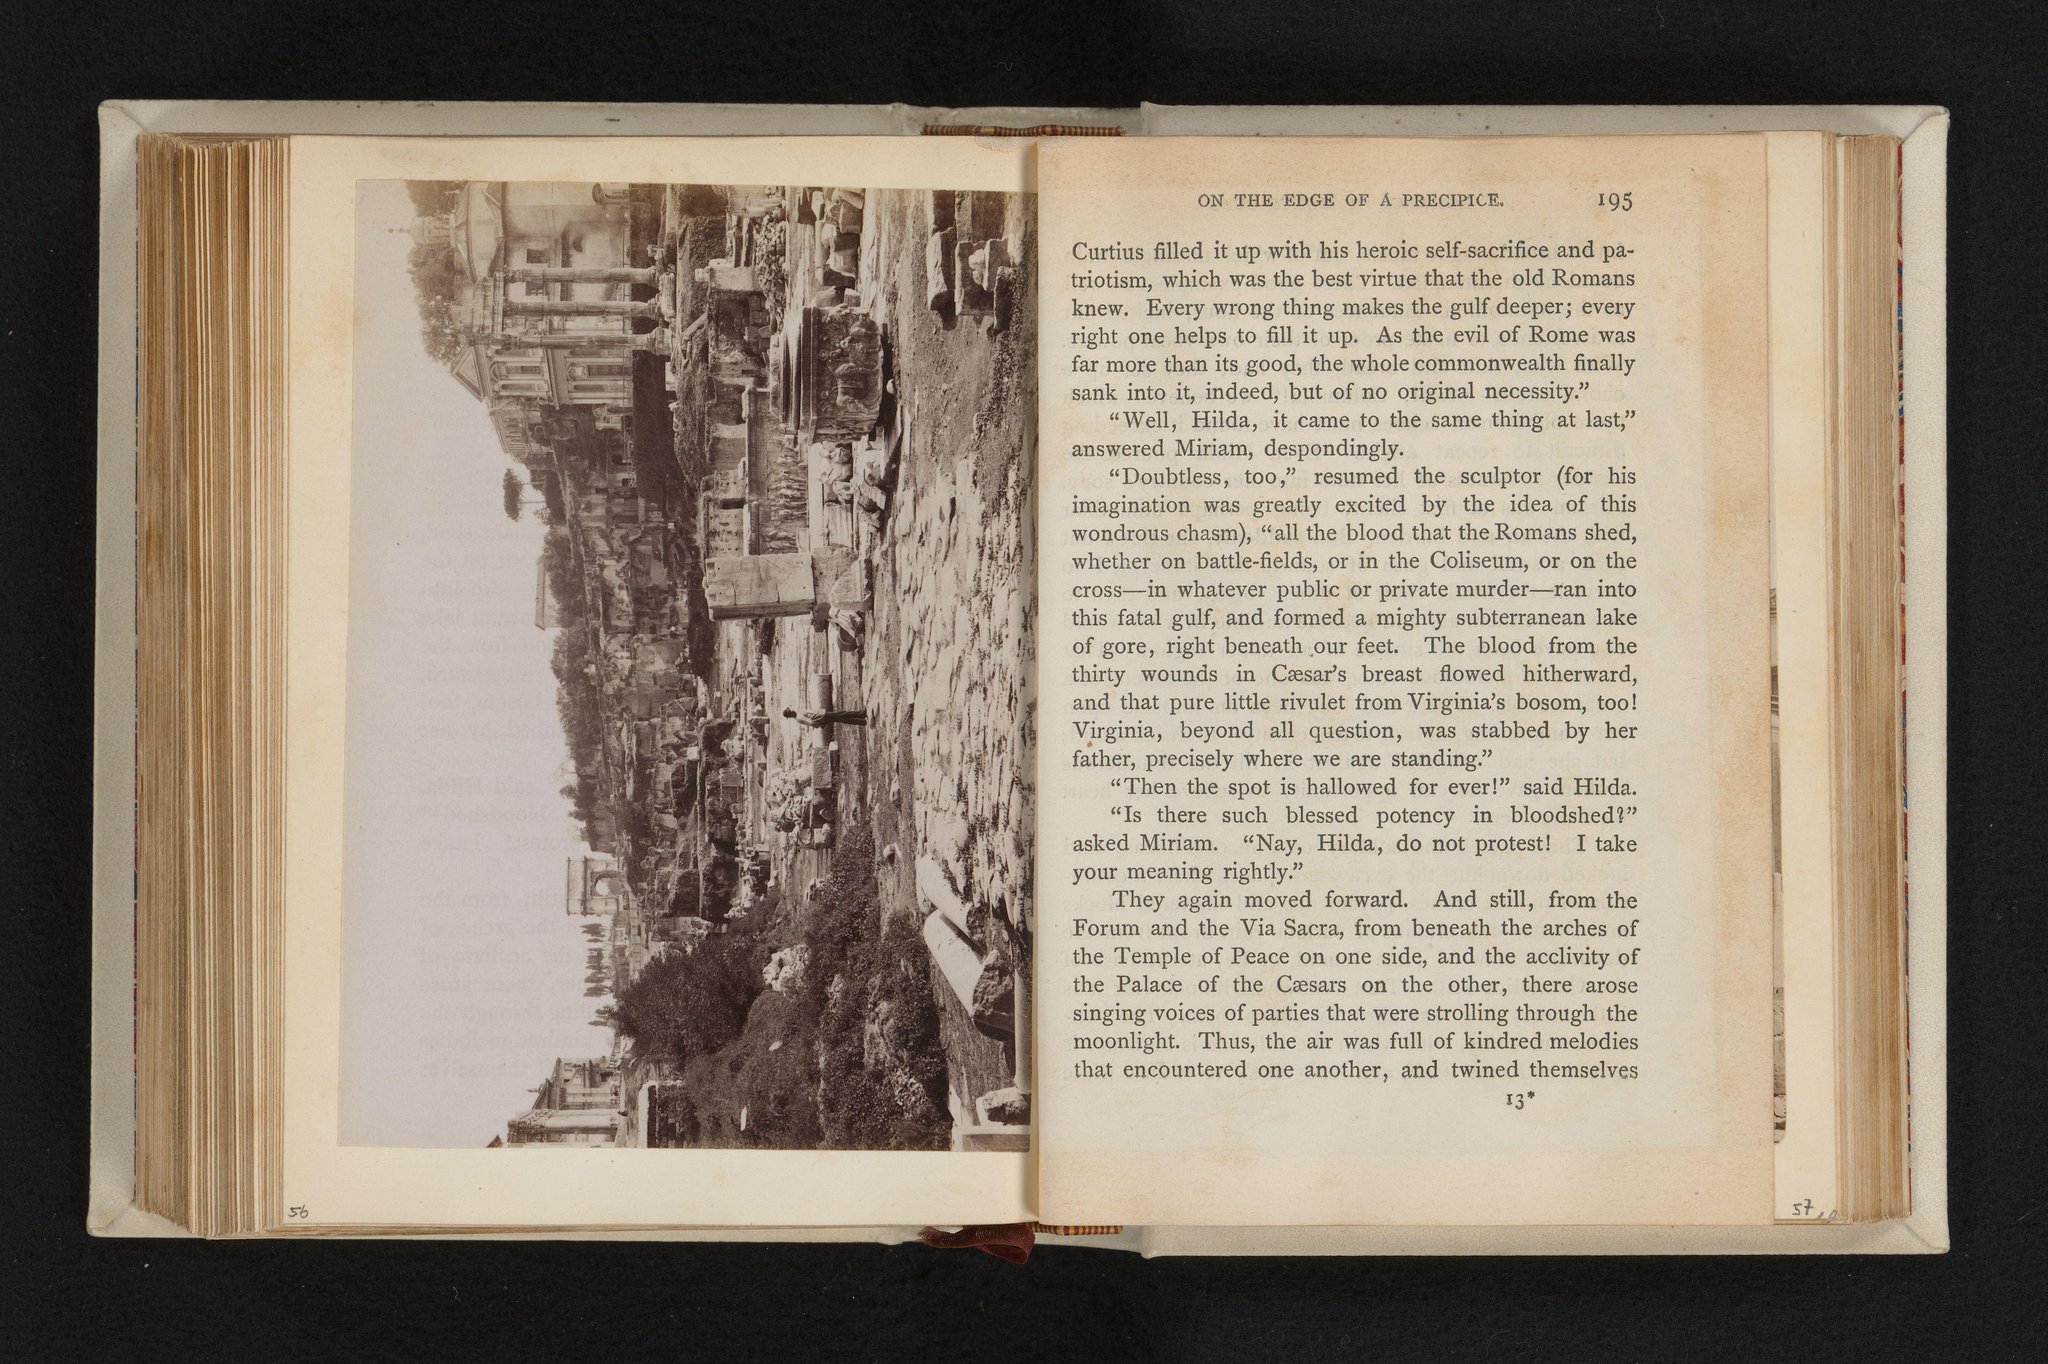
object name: page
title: Gezicht op het Forum Romanum in Rome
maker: Anonymous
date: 1850-1860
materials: photographic support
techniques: albumen print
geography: rome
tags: landscape with ruins